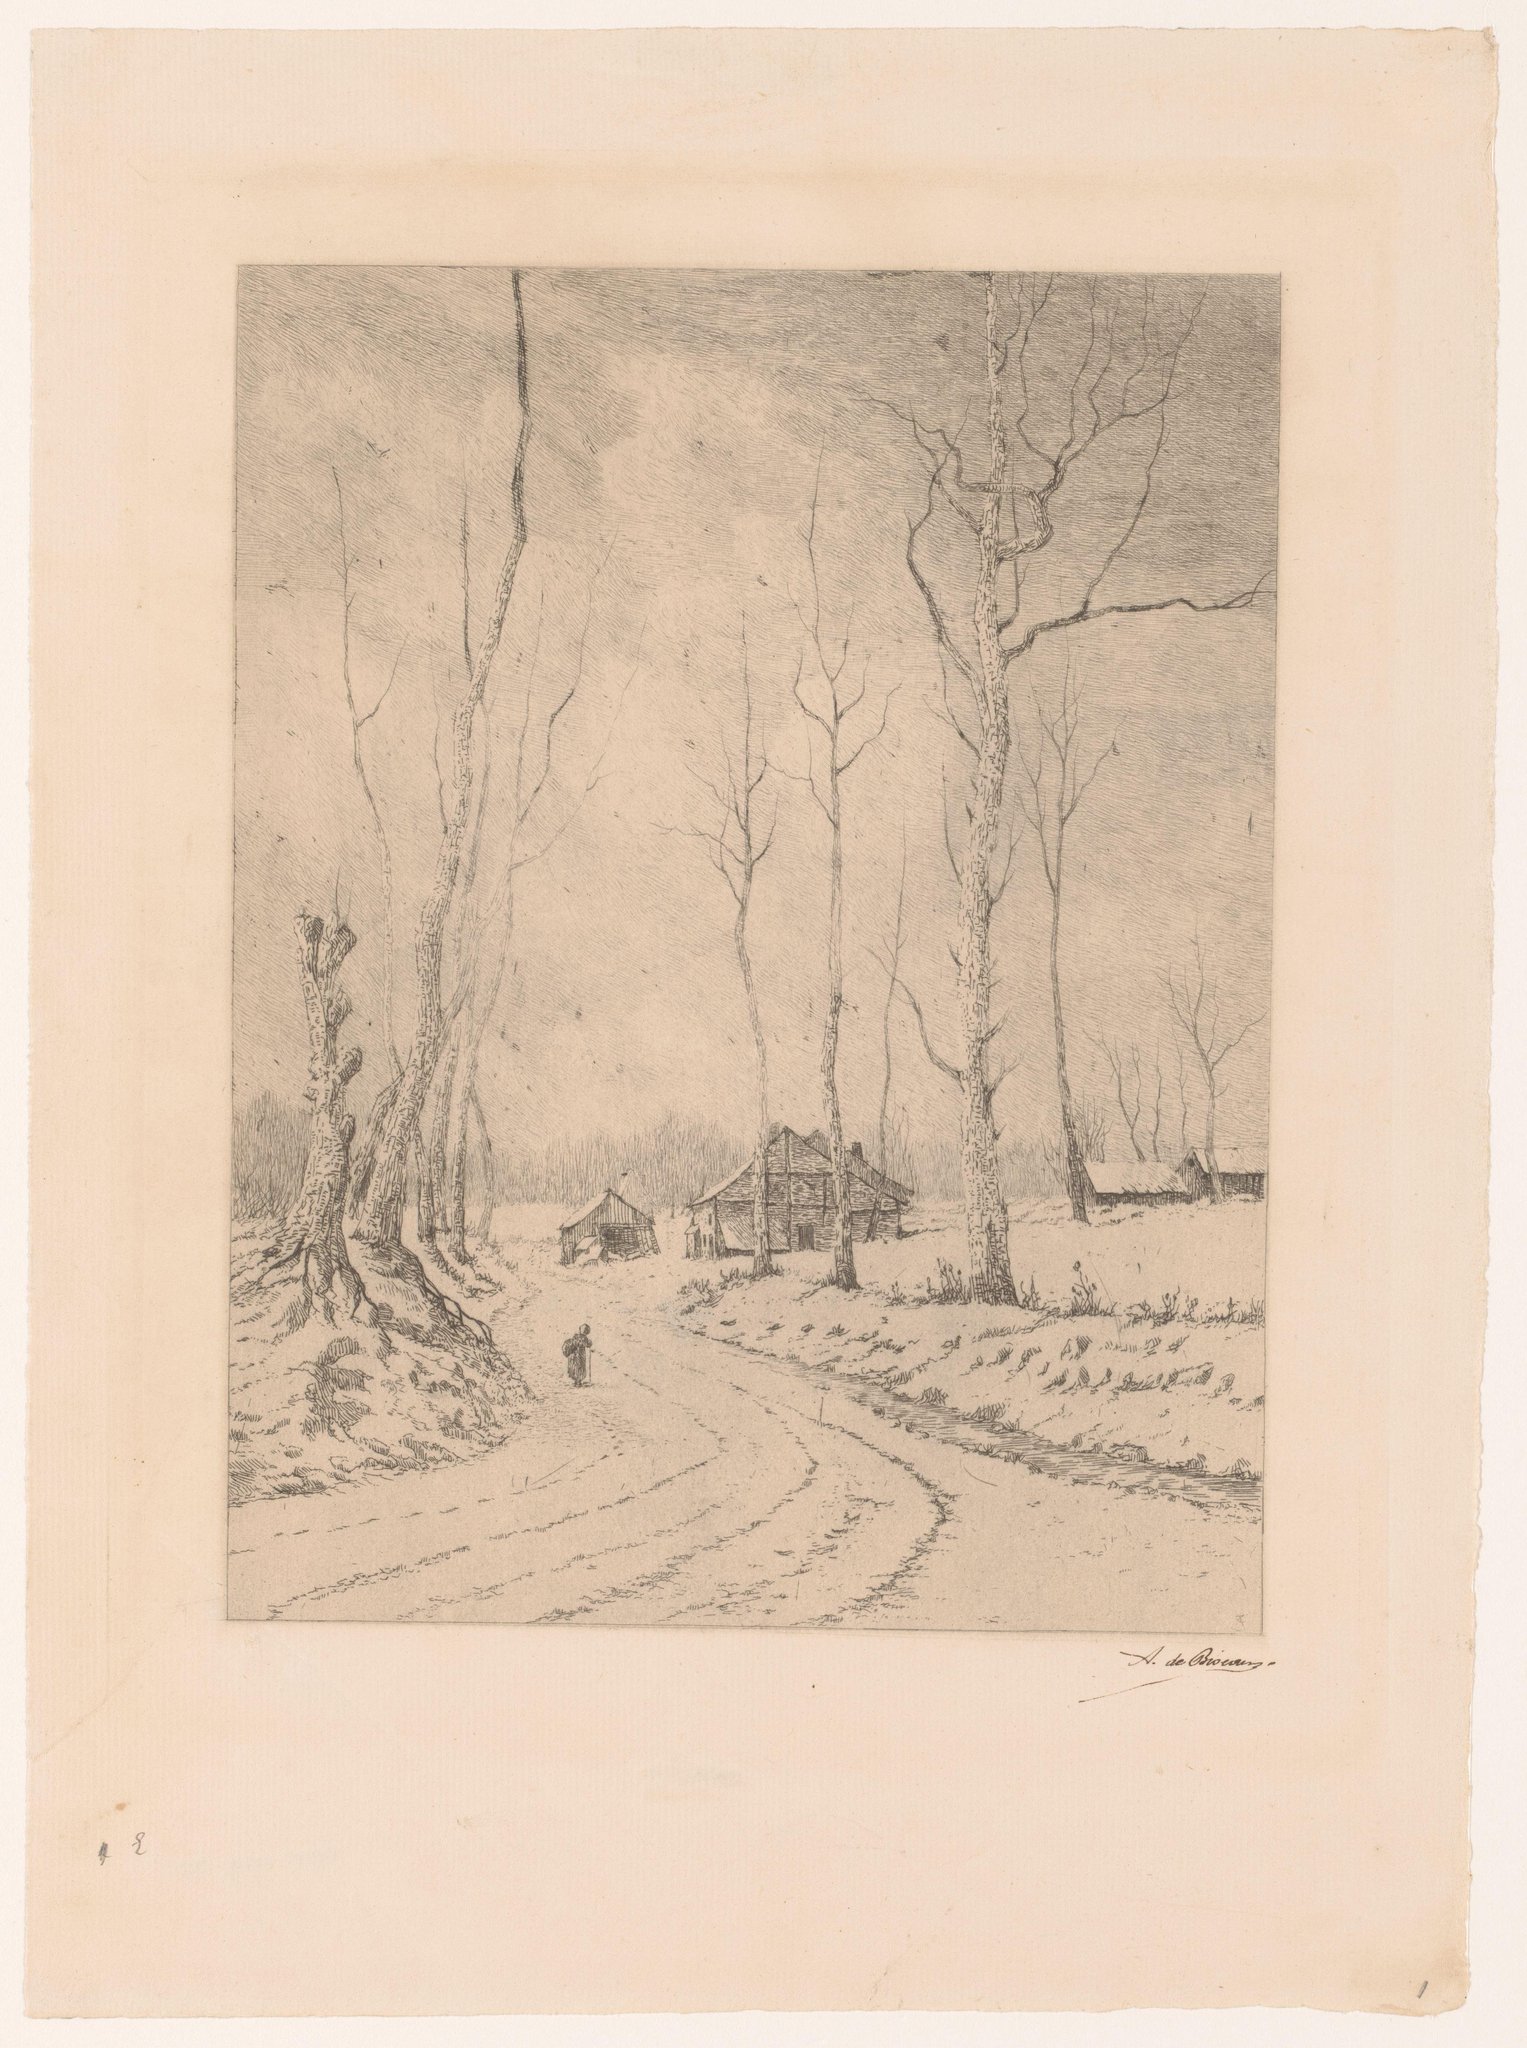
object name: print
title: Hiver à Auderghem (Belgique)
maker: aristide de biseau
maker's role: print maker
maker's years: 1844-1883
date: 1854-1883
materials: paper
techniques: etching, intaglio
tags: forest path or lane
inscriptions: collector's mark: Lugt 2228